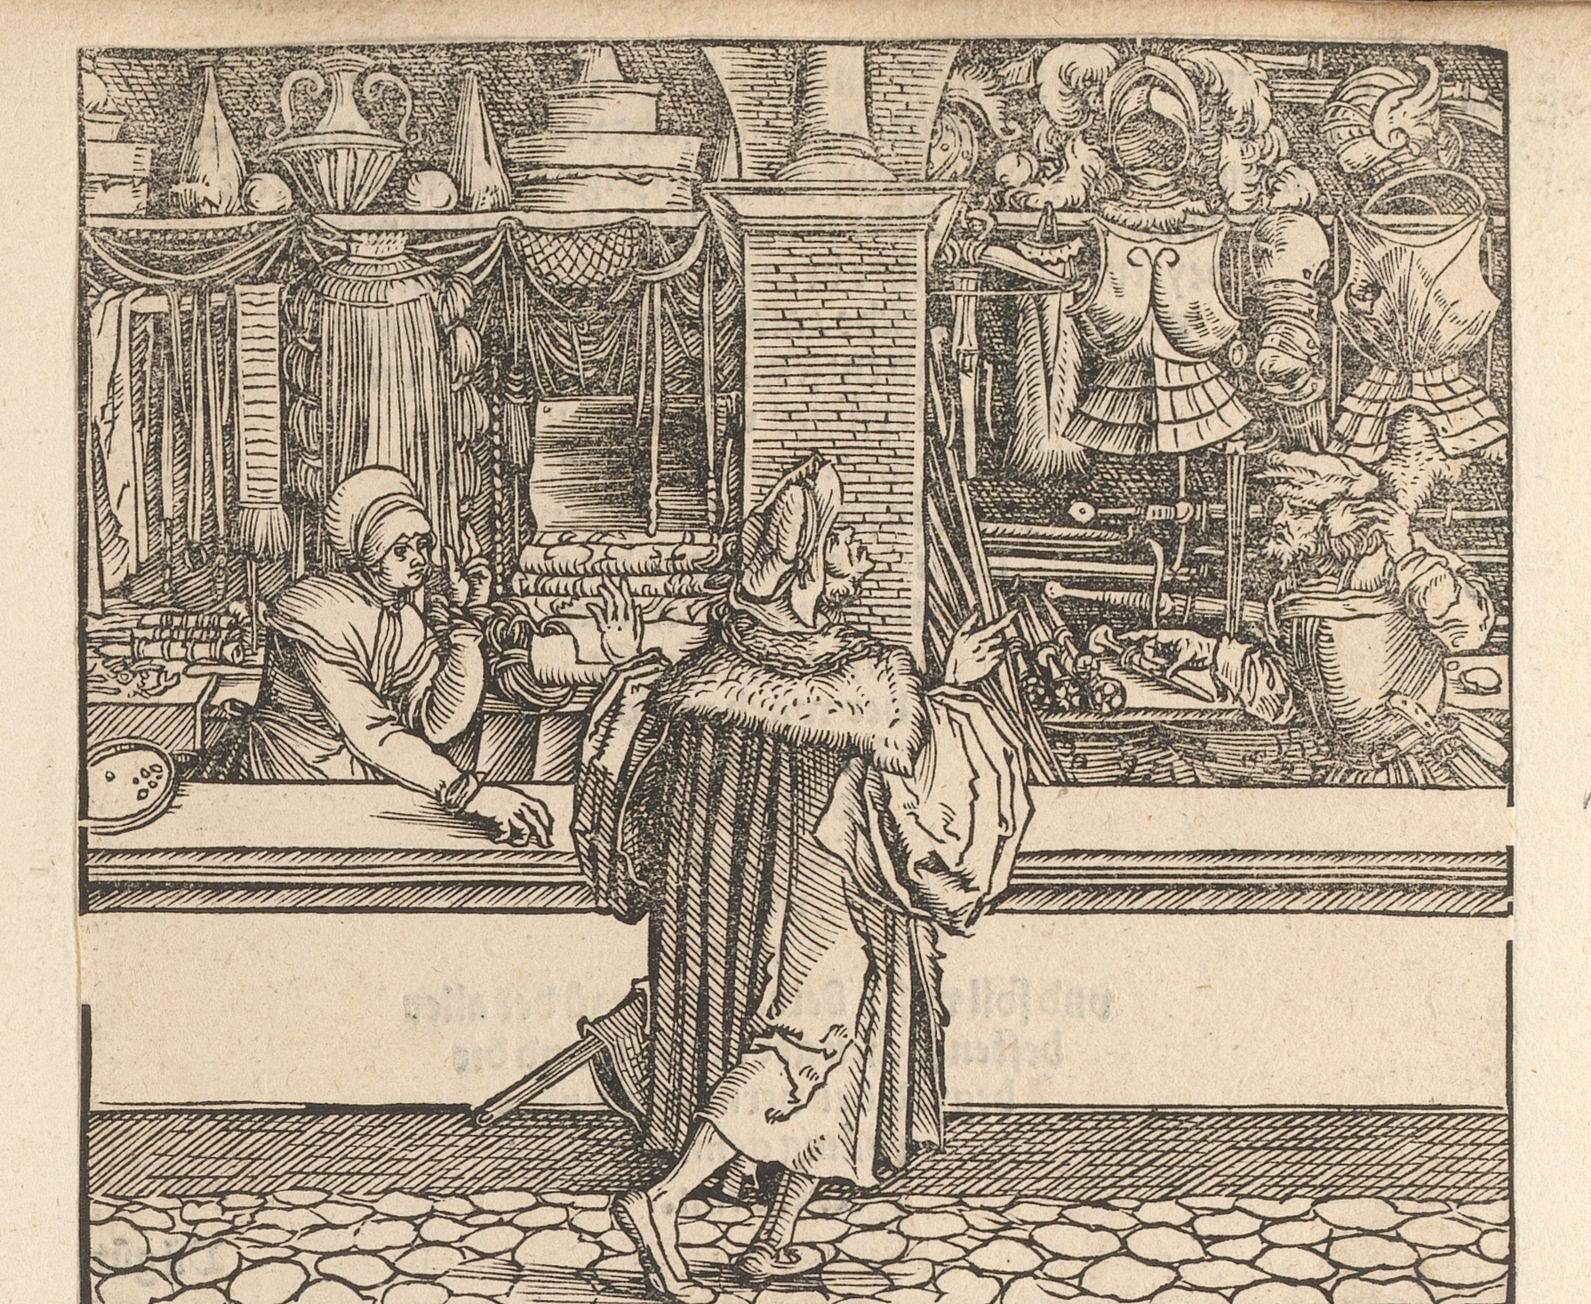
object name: book illustration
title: Man loopt langs een stoffenwinkel naar een wapenhandel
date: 1514-1531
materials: paper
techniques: letterpress printing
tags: military clothing and other equipment (uniforms, cap, armour, helmet, etc.), merchant, salesman, textile fabric, cloth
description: Deze prent is gebruikt in: Cicero, Marcus Tulius. Officia M.T.C. Ein Buch so Marcus Tullius Cicero der Römer zu seynem (...). [Vertaald uit het Latijn door] Johann von Schwarzenberg. Augsburg: Heinrich Steiner, 1531.